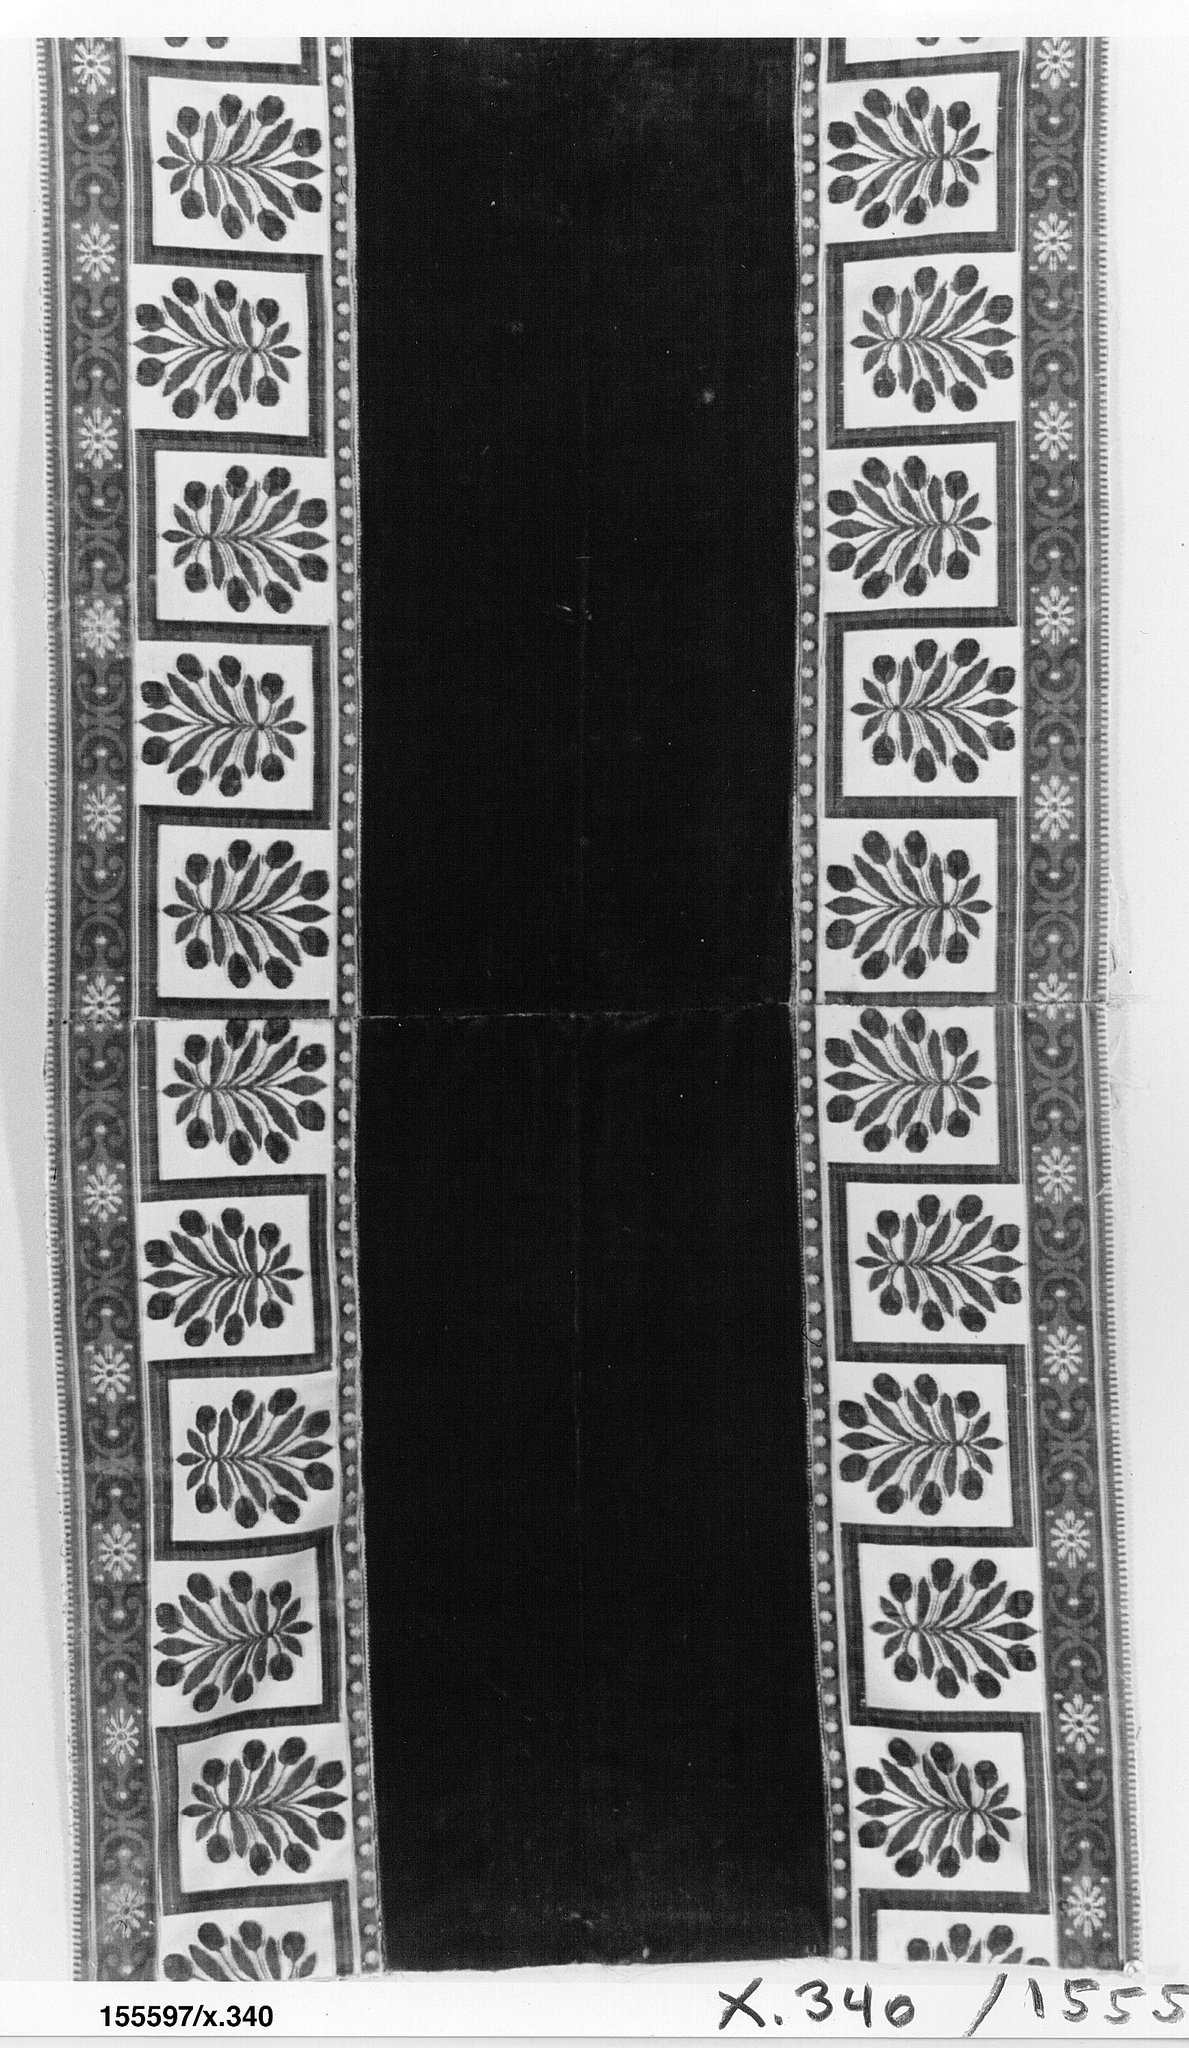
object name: piece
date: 1880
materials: silk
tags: leaves